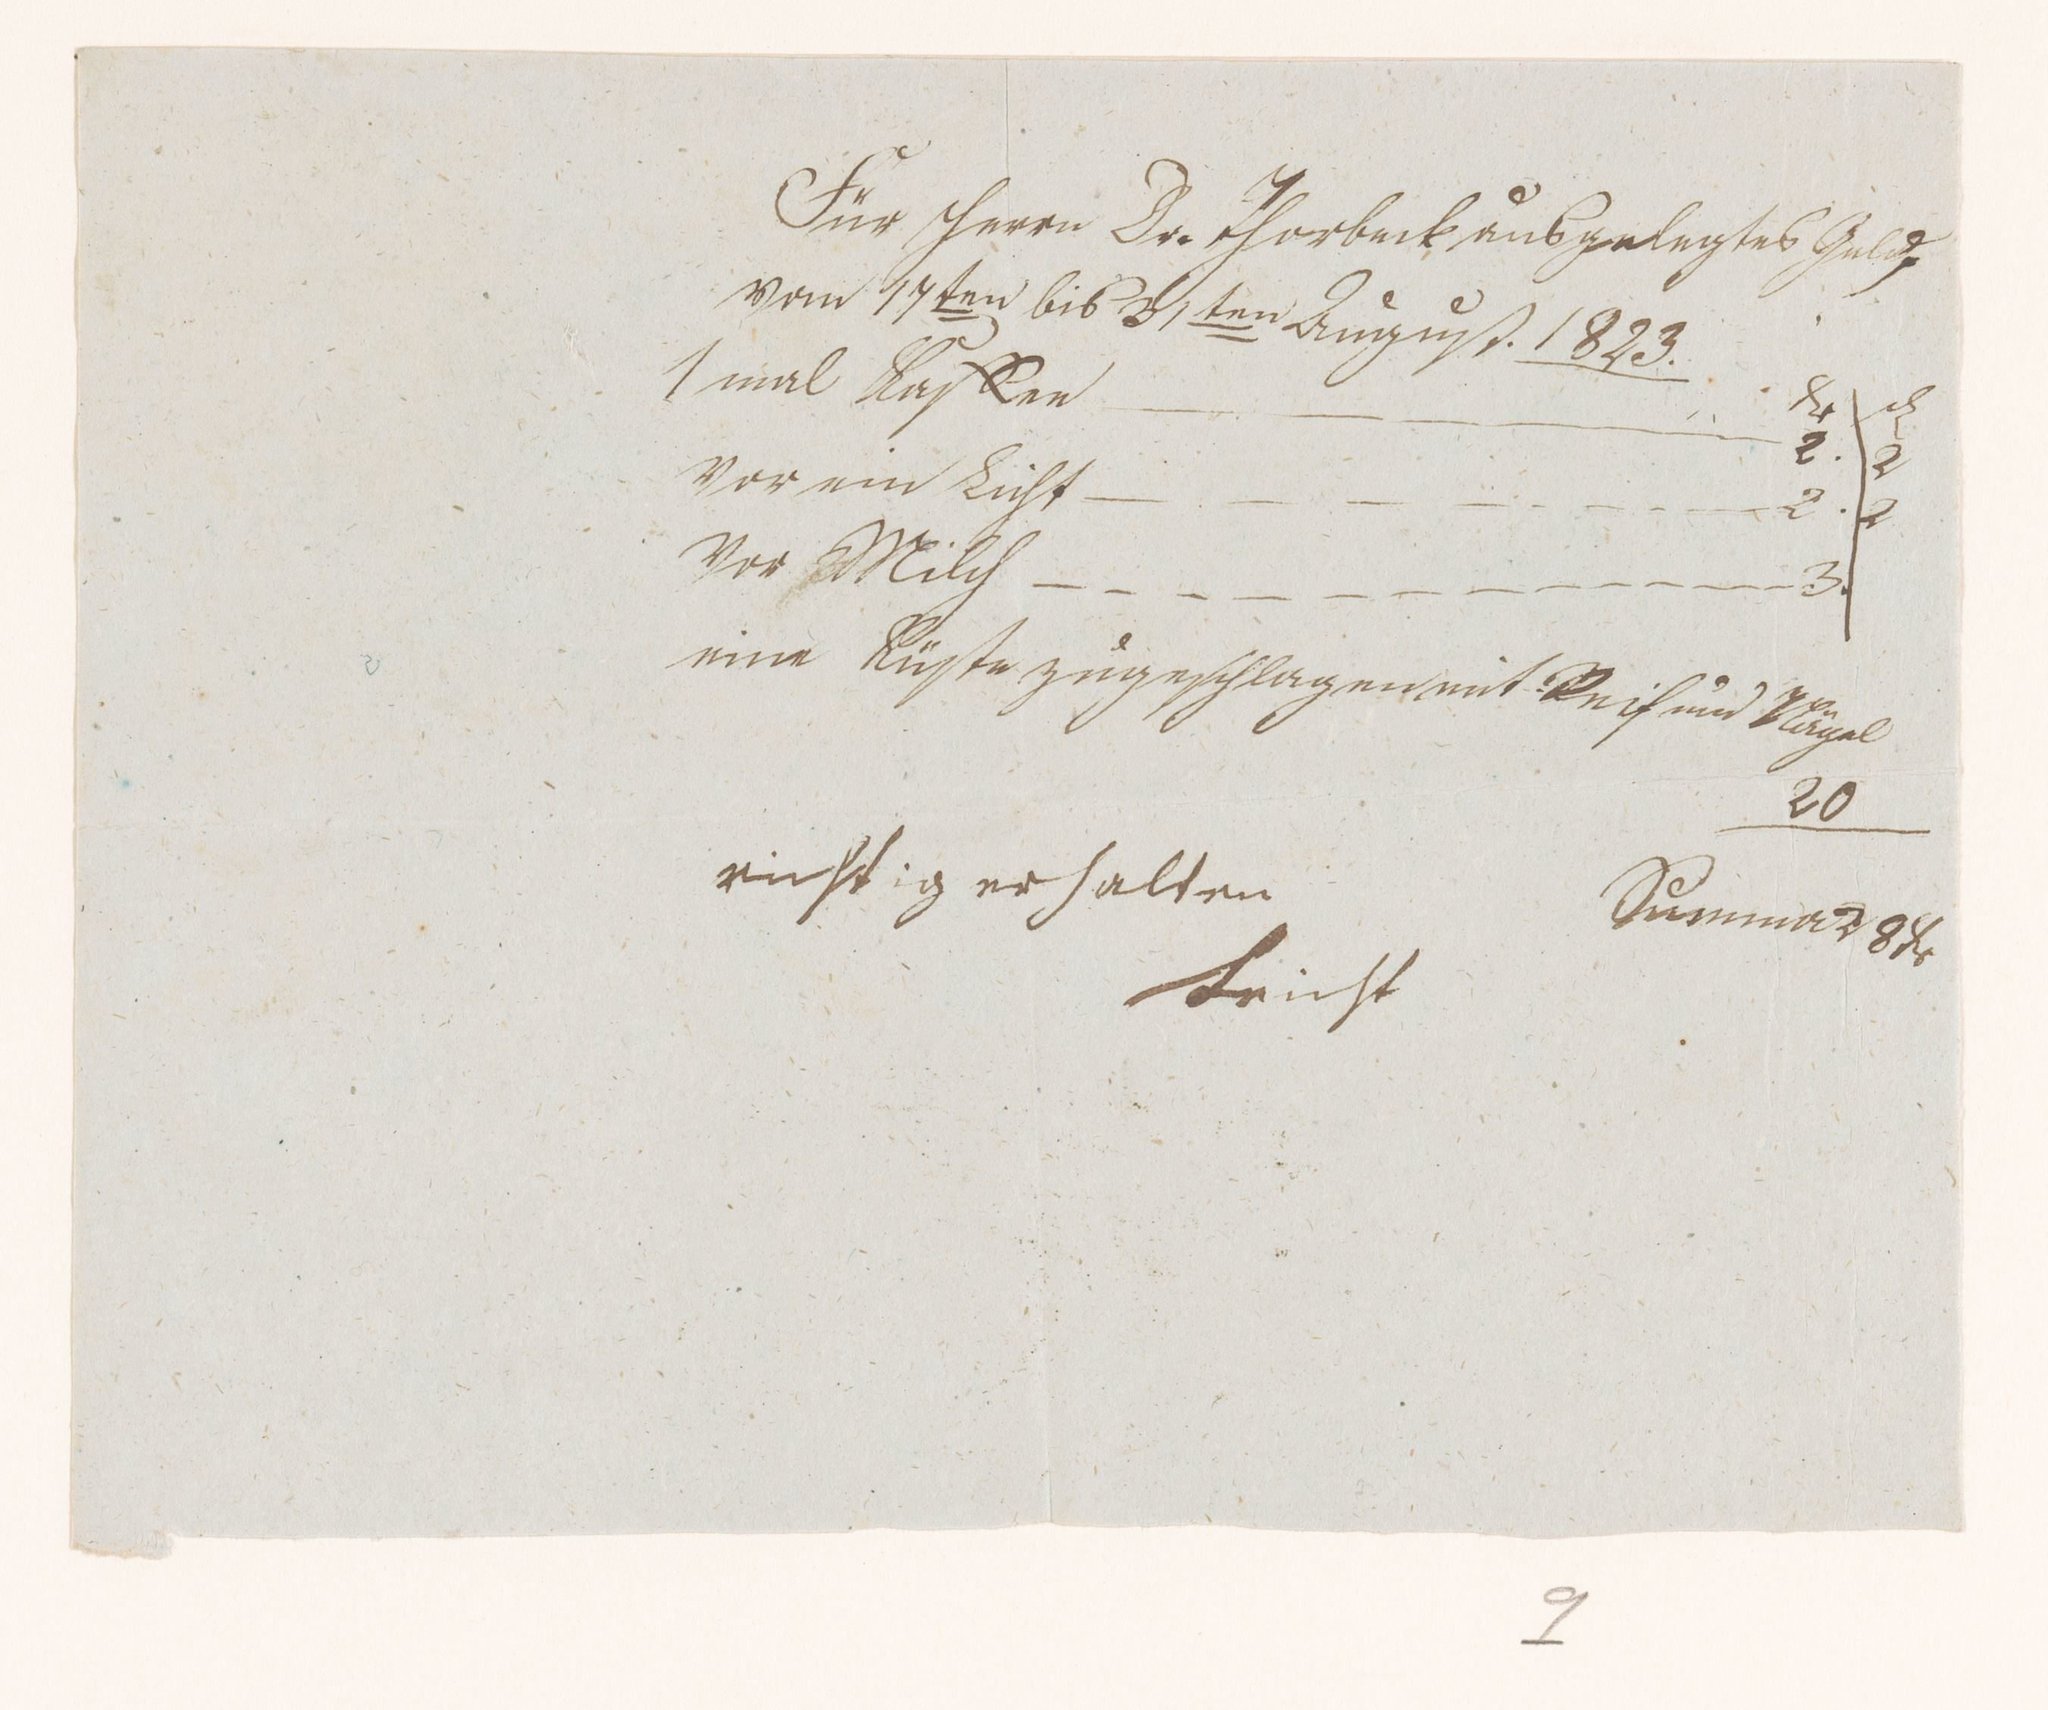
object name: document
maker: Anonymous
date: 1808-1823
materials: ink, paper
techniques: printing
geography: germany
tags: the hague, johan rudolf thorbecke, germany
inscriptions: date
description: Rekening voor levensmiddelen, Giessen. Gedateerd: 1 aug. 1823.